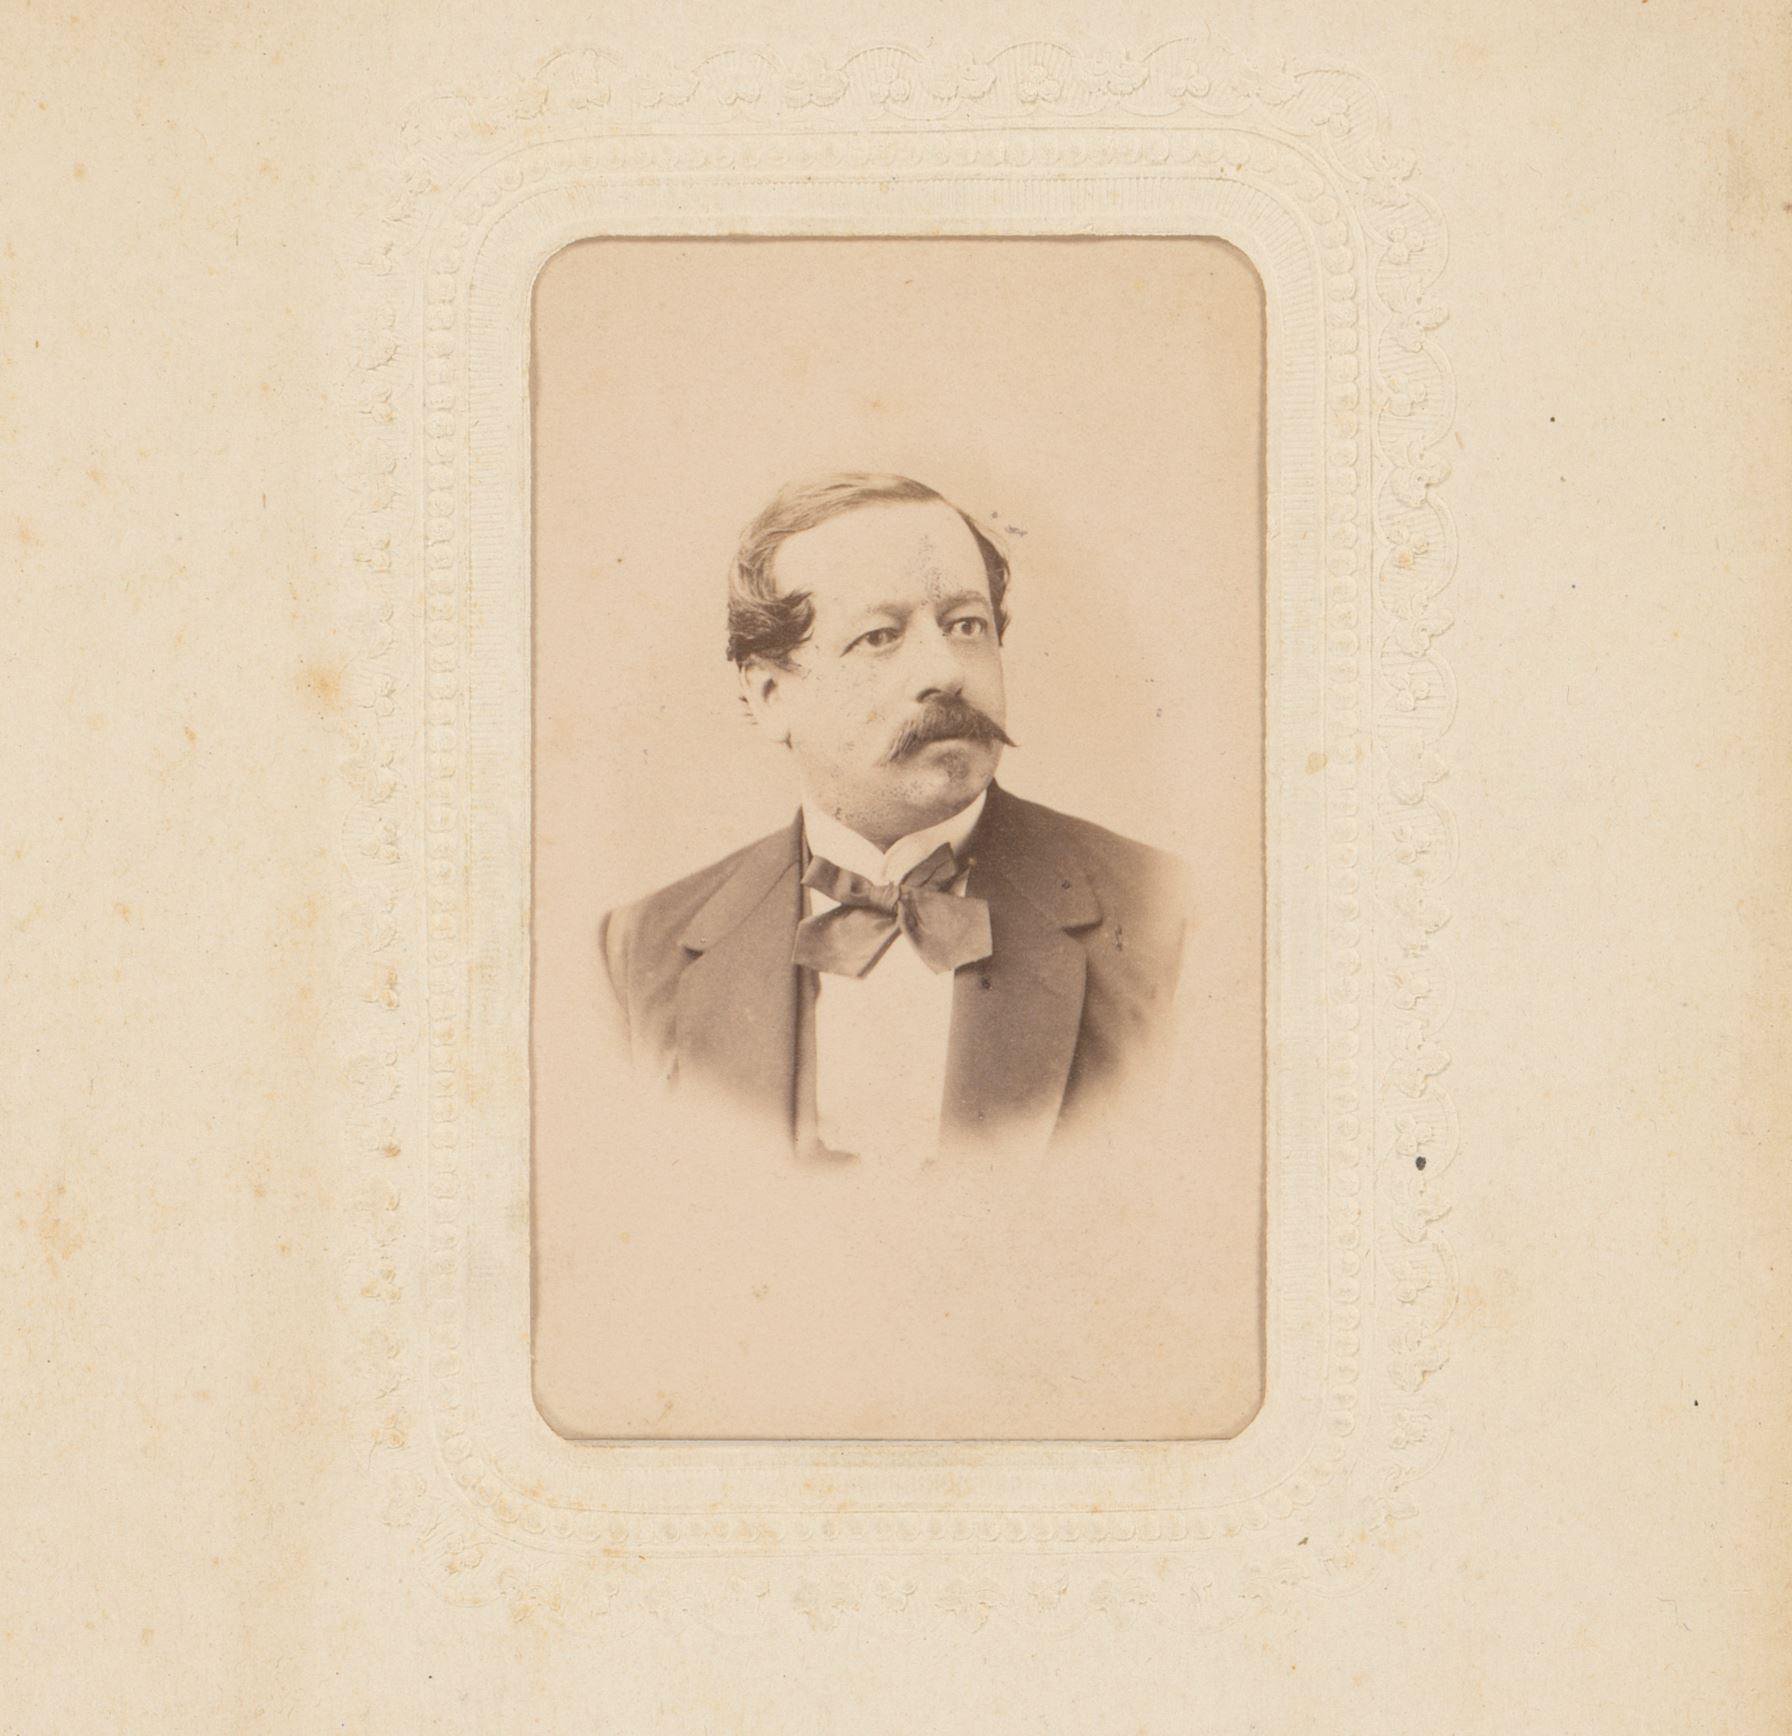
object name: carte de visite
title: Portret van een man met snor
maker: eugene guérin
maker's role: fotograaf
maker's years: 1845-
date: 1868-1890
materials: cardboard, photographic support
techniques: albumen print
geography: brussels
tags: moustache, historical persons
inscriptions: inscription: ‘Eugène Guérin/ Bruxelles’, inscription: ‘Guérin/ Bruxelles/ 32, Rue de Louvain’